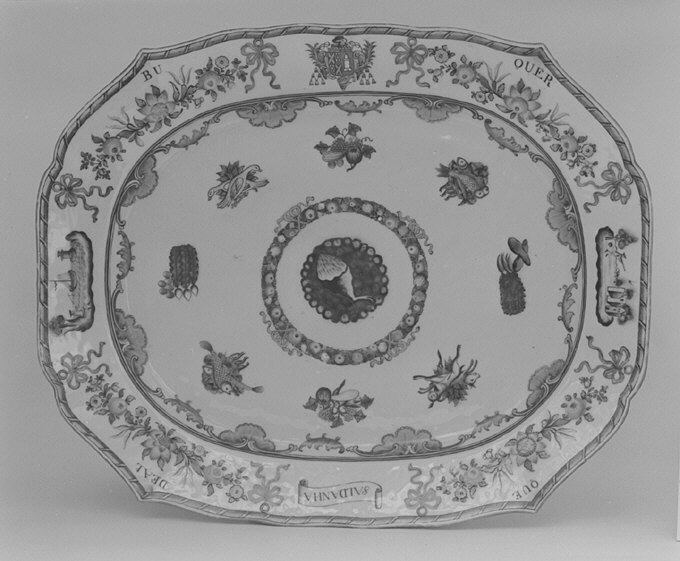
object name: platter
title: Platter (part of a service)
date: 1765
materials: hard paste porcelain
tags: birds,flowers